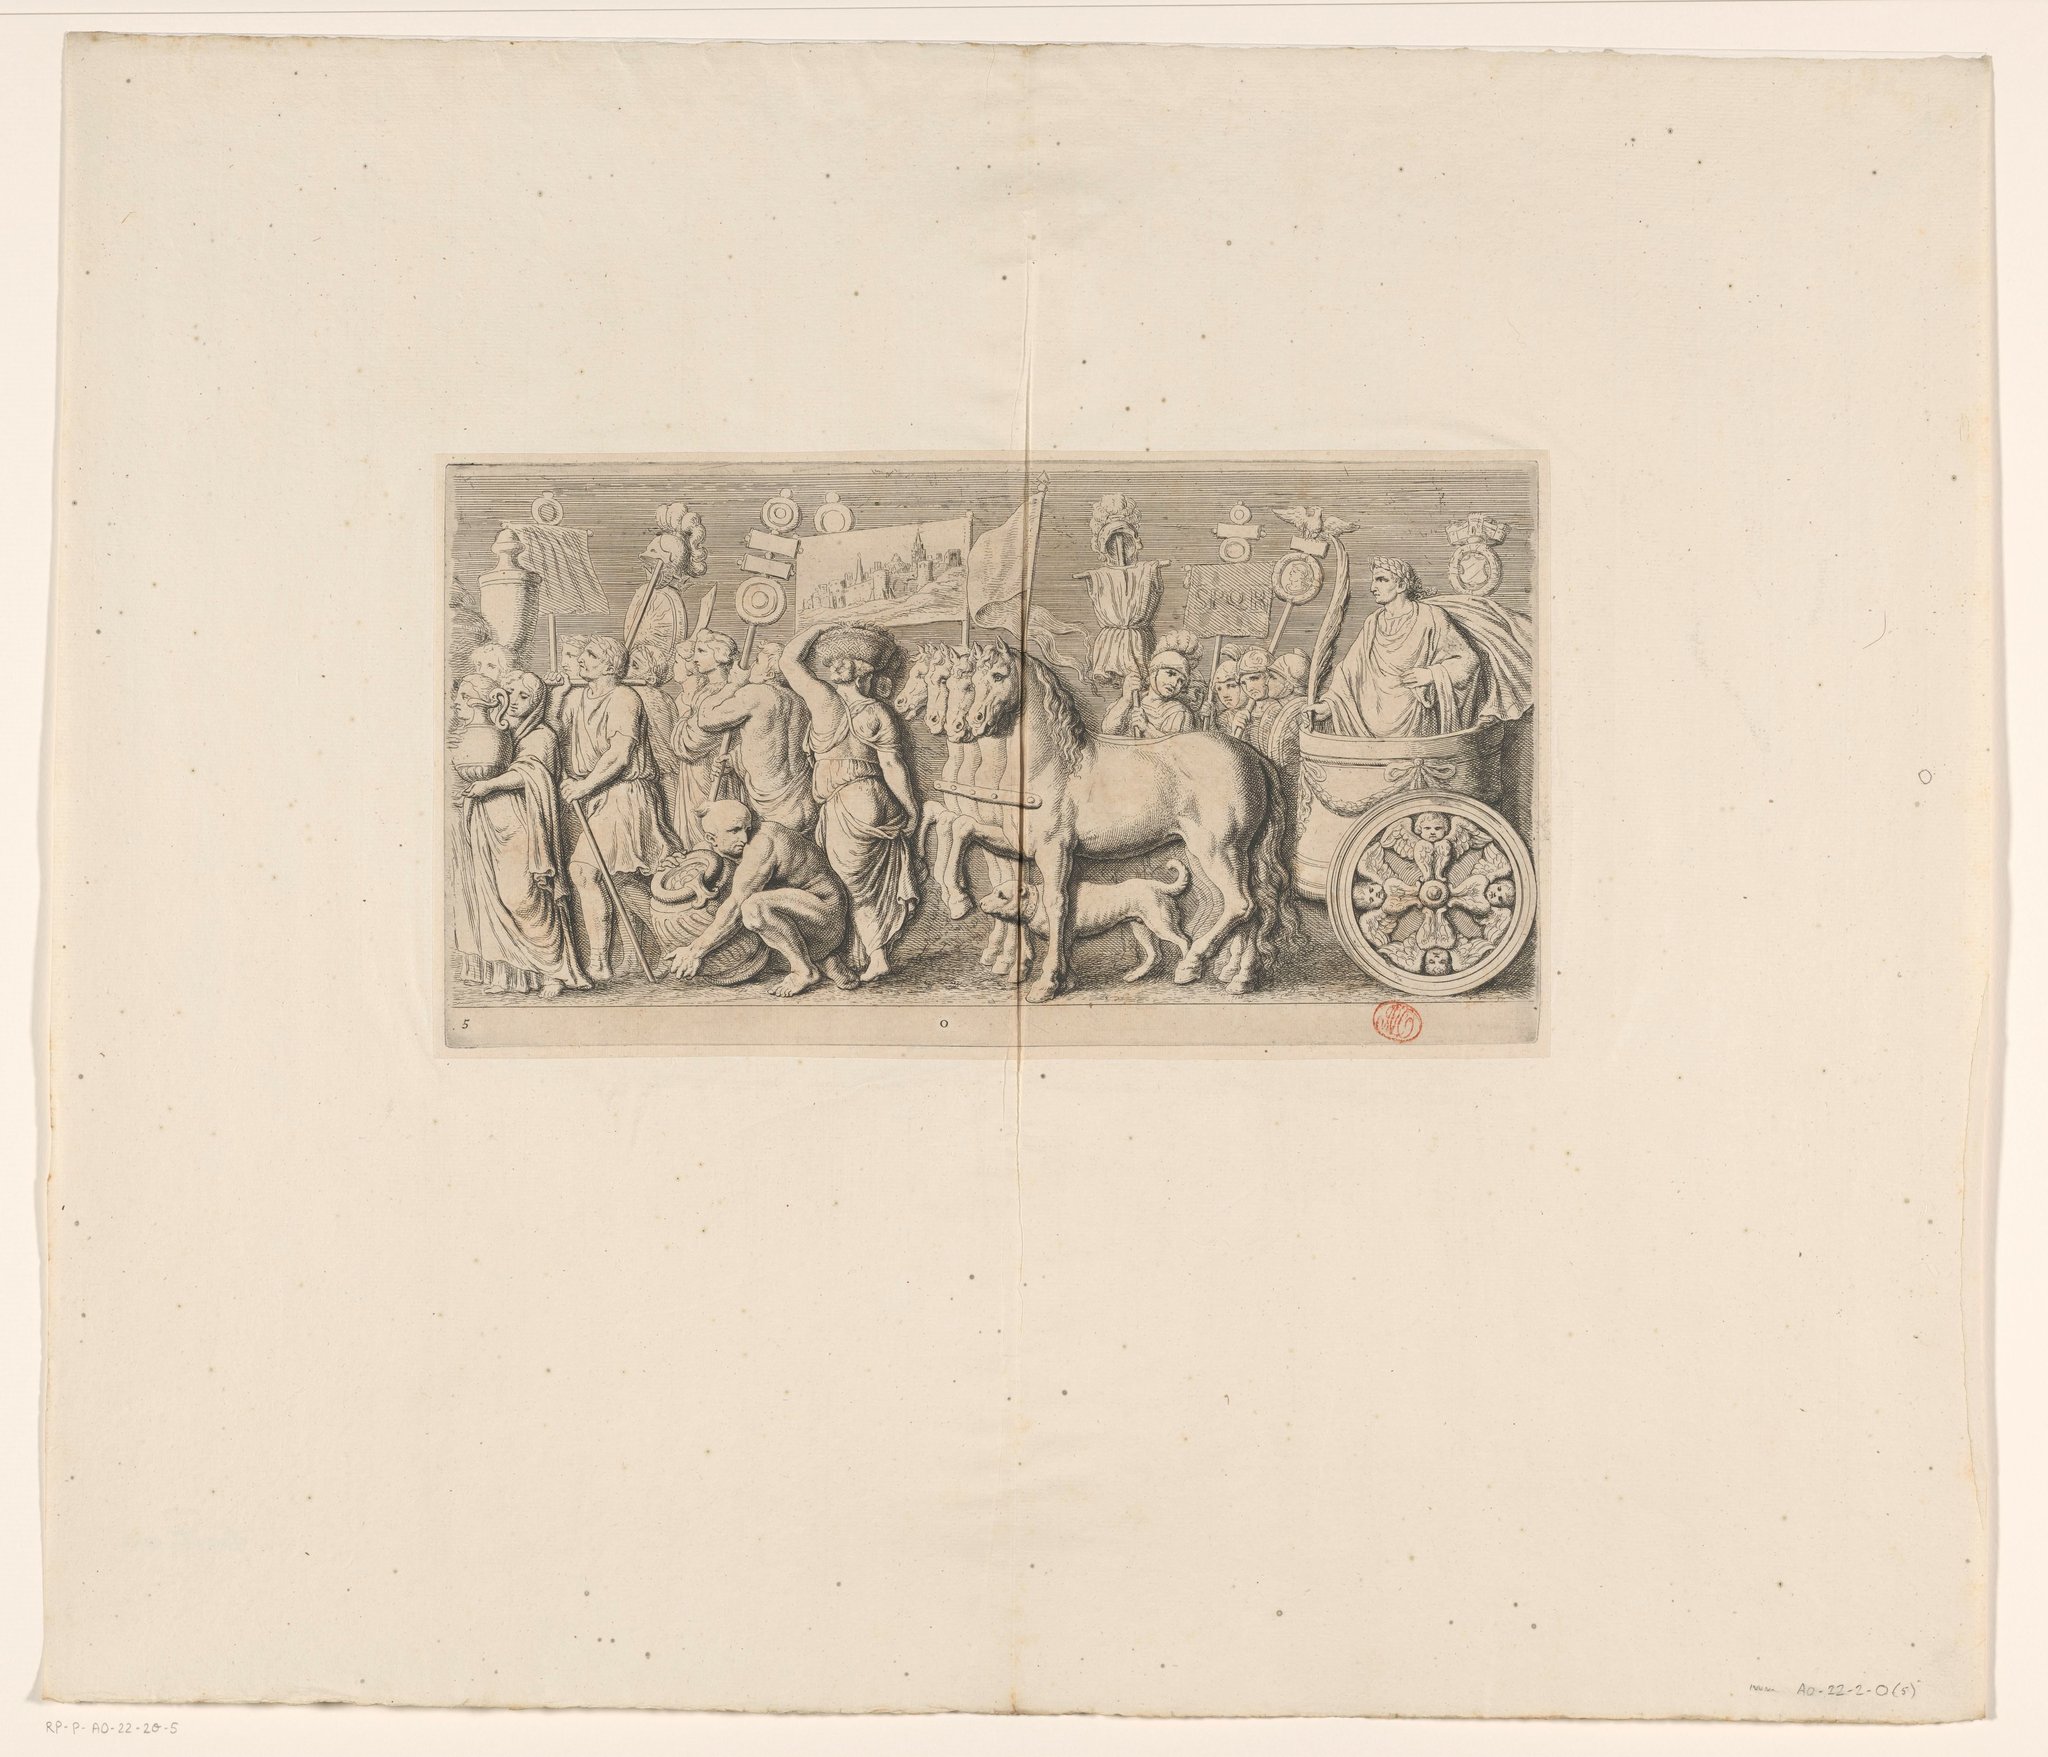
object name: print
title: Fries met triomftocht van Quintus Fabius Maximus op schouw in Burgemeesterskamer van het Stadhuis op de Dam (vijfde deel)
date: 1663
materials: paper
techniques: engraving, etching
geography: amsterdam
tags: triumphal entry and public reception, pageant, 'entrée solennelle', 'joyeuse entrée', trophy ~ battle, war, triumphs (allegorical and symbolic), conqueror triumphing, triumphal entry of victor, roman chariot, quadriga ~ triumph, (military) flags and standards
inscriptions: collector's mark: Lugt 195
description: Aangezien er meerdere (in ieder geval vier) Quinti Fabii Maximi zijn geweest die consul waren en één of meerdere triomftochten hebben gekregen, is niet met zekerheid te zeggen om welke triomftocht en welke Quintus Fabius Maximus het gaat. Maar het is waarschijnlijk dat het gaat om Quintus Fabius Maximus Verrucosus Cunctator (ca. 275 v.Chr. - 203 v.Chr.), die is afgebeeld op het schilderij van Jan Lievens dat boven de schouw hangt. Op dit schilderij is te zien hoe hij, in 213 v.Chr., op bevel van zijn naamgenoot en zoon Quintus Fabius Maximus - die in dat jaar consul was - van zijn paard afstijgt. Zijn zoon is maar eenmaal consul geweest en heeft geen triomfen behaald. Prent gebruikt in: Secunca pars Praecipuarum effigierum ac ornamentorum amplissime Curiae Amstelrodamensis maiori ex parte in cadido marmore effectorum per Artum Quellinium eiusdem Civitatis Statuarium / Het tweede deel Van de voornaemste Statuen ende Cieraten van 't konst-rijcke Stadt-huys van Amstelredam 'tmeeste in Marmer gemaeckt door Artus Quellinus Beelthouwer der voorseyde Stadt. Amsterdam: Artus Quellinus (I), 1663. Zie RP-P-AO-22-2-1 voor bijhorende titelpagina. Zie RP-P-AO-22-2-2 voor bijhorend register. Zie RP-P-AO-22-2A, RP-P-AO-22-2B, RP-P-AO-22-2C-1, RP-P-AO-22-2C-2, RP-P-AO-22-2C-3, RP-P-AO-22-2C-4, RP-P-AO-22-2D-1, RP-P-AO-22-2D-2, RP-P-AO-22-2D-3, RP-P-AO-22-2E-1, RP-P-AO-22-2E-2, RP-P-AO-22-2E-3, RP-P-AO-22-2E-4, RP-P-AO-22-2F-1, RP-P-AO-22-2F-2, RP-P-AO-22-2F-3, RP-P-AO-22-2G, RP-P-AO-22-2H, RP-P-AO-22-2I, RP-P-AO-22-2K, RP-P-AO-22-2L, RP-P-AO-22-2M, RP-P-AO-22-2N, RP-P-AO-22-2O-1, RP-P-AO-22-2O-2, RP-P-AO-22-2O-3, RP-P-AO-22-2O-4, RP-P-AO-22-2O-6, RP-P-AO-22-2O-7, RP-P-AO-22-2P-1, RP-P-AO-22-2P-2, RP-P-AO-22-2Q-1, RP-P-AO-22-2Q-2, RP-P-AO-22-2Q-3, RP-P-AO-22-2R-1, RP-P-AO-22-2R-2, RP-P-AO-22-2R-3, RP-P-AO-22-2S, RP-P-AO-22-2T-1, RP-P-AO-22-2T-2, RP-P-AO-22-2T-3, RP-P-AO-22-2T-4, RP-P-AO-22-2V-1, RP-P-AO-22-2V-2, RP-P-AO-22-2W-1, RP-P-AO-22-2W-2, RP-P-AO-22-2X-1, RP-P-AO-22-2X-2 en RP-P-AO-22-2X-3 voor andere prenten uit deze publicatie. Zelfde staat van prent ook gebruikt in: Secunca pars Praecipuarum effigierum ac ornamentorum amplissime Curiae Amstelrodamensis maiori ex parte in cadido marmore effectorum per Artum Quellinium eiusdem Civitatis Statuarium / Het tweede deel Van de voornaemste Statuen ende Cieraten van 't konst-rijcke Stadt-huys van Amstelredam 'tmeeste in Marmer gemaeckt door Artus Quellinus Beelthouwer der voorseyde Stadt. Amsterdam: Frederik de Wit, 1668. Latere staat van prent ook gebruikt in: Architecture peinture et sculpture de la Maison de Ville d'Amsterdam, representee en CIX. figures en taille-douce (…). Amsterdam: David Mortier, 1719. En in: Architecture peinture et sculpture de la Maison de Ville d'Amsterdam, representee en CIX. figures en taille-douce (…). Amsterdam: Gerard Valck, 1719. En in: Bouw schilder en beeldhouwkonst, van het Stadhuis te Amsteldam, vertoont in CIX figuuren (…). Amsterdam: Covens & Mortier & Covens Jr., s.a. (1774-1783).